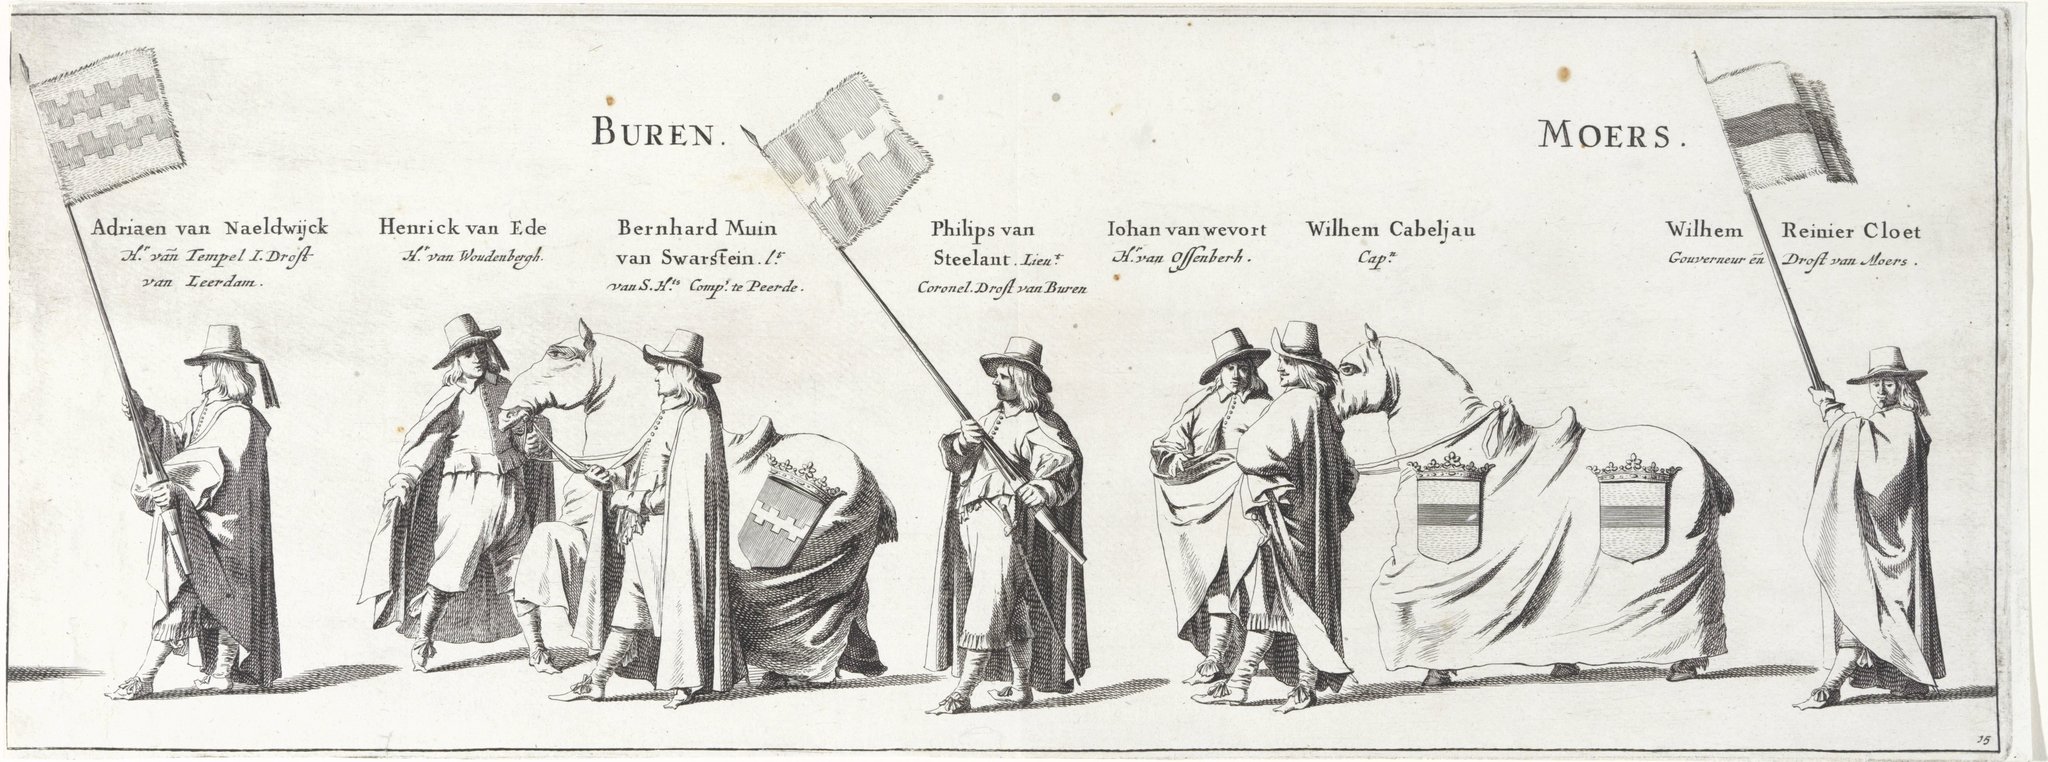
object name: print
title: De begrafenisstoet van Frederik Hendrik (plaat nr. 15), 1647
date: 1651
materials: paper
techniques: engraving, etching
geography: amsterdam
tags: cortege, funeral procession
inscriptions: collector's mark: Lugt 2228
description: De begrafenisstoet van stadhouder Frederik Hendrik te 's-Gravenhage op 10 mei 1647. Plaat nr. 15 met een deel van de stoet met vaandeldragers en twee paarden, boven de personen staan hun naam en functie. Onderdeel van een serie van 30 platen en 20 tekstbladen, bedoeld om aan elkaar geplakt te worden.